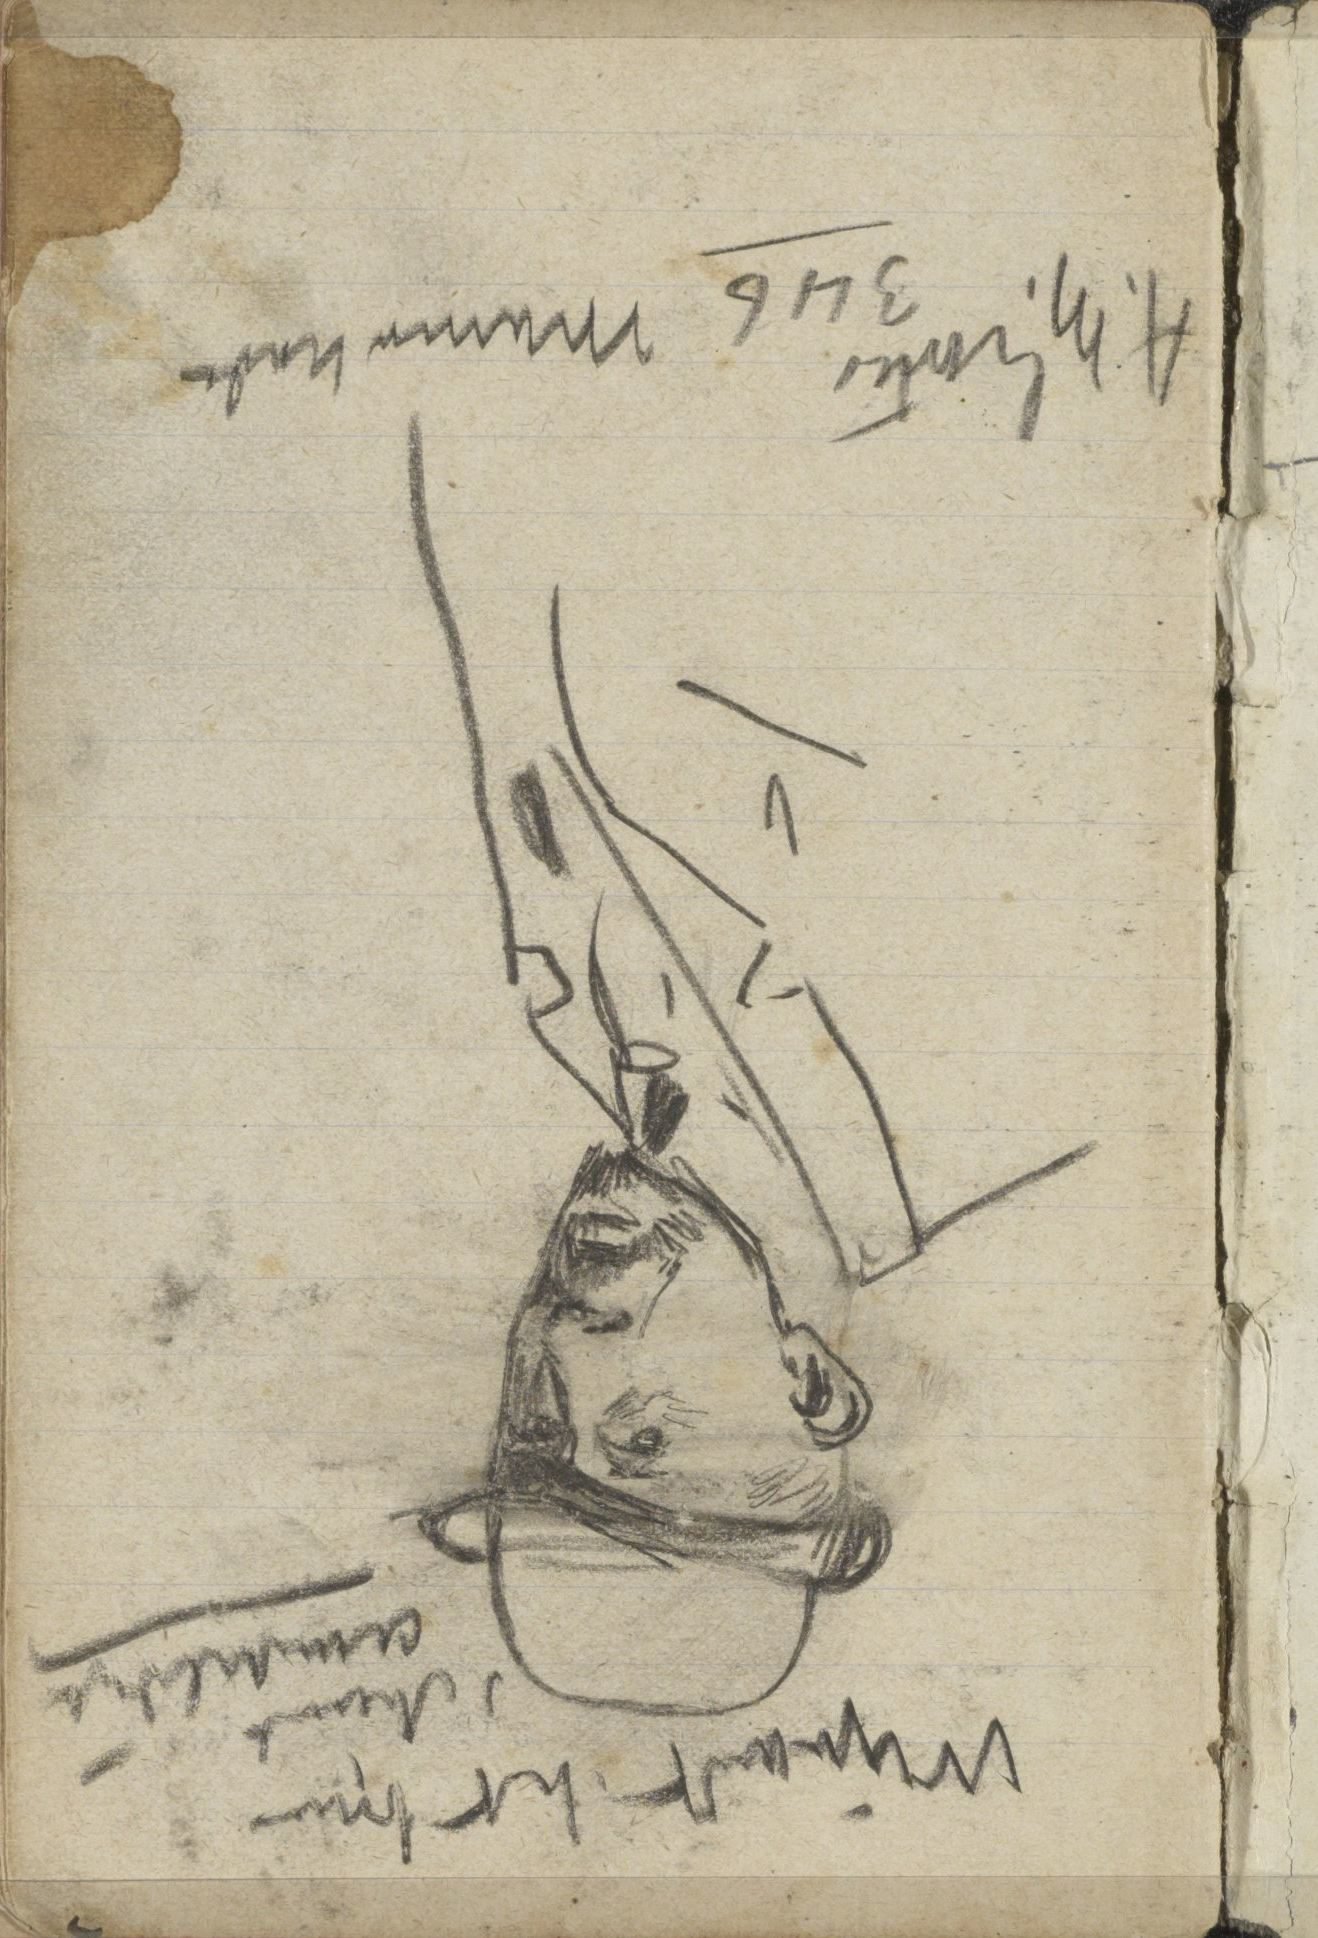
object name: sketchbook leaf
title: Mansportret, waarschijnlijk een zelfportret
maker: george hendrik breitner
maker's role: draughtsman, painter, print maker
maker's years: 1857-1923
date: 1886-1903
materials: chalk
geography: amsterdam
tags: rotterdam, amsterdam, painter, print maker, draughtsman, george hendrik breitner, anonymous historical person portrayed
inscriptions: annotation: ‘Wijnandt[?] het bruin[?]/ [...]/ Amsteldijk/ A.M. Gorter/ 346 Nassaukade’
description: Pagina 81 uit een schetsboek met 41 bladen.